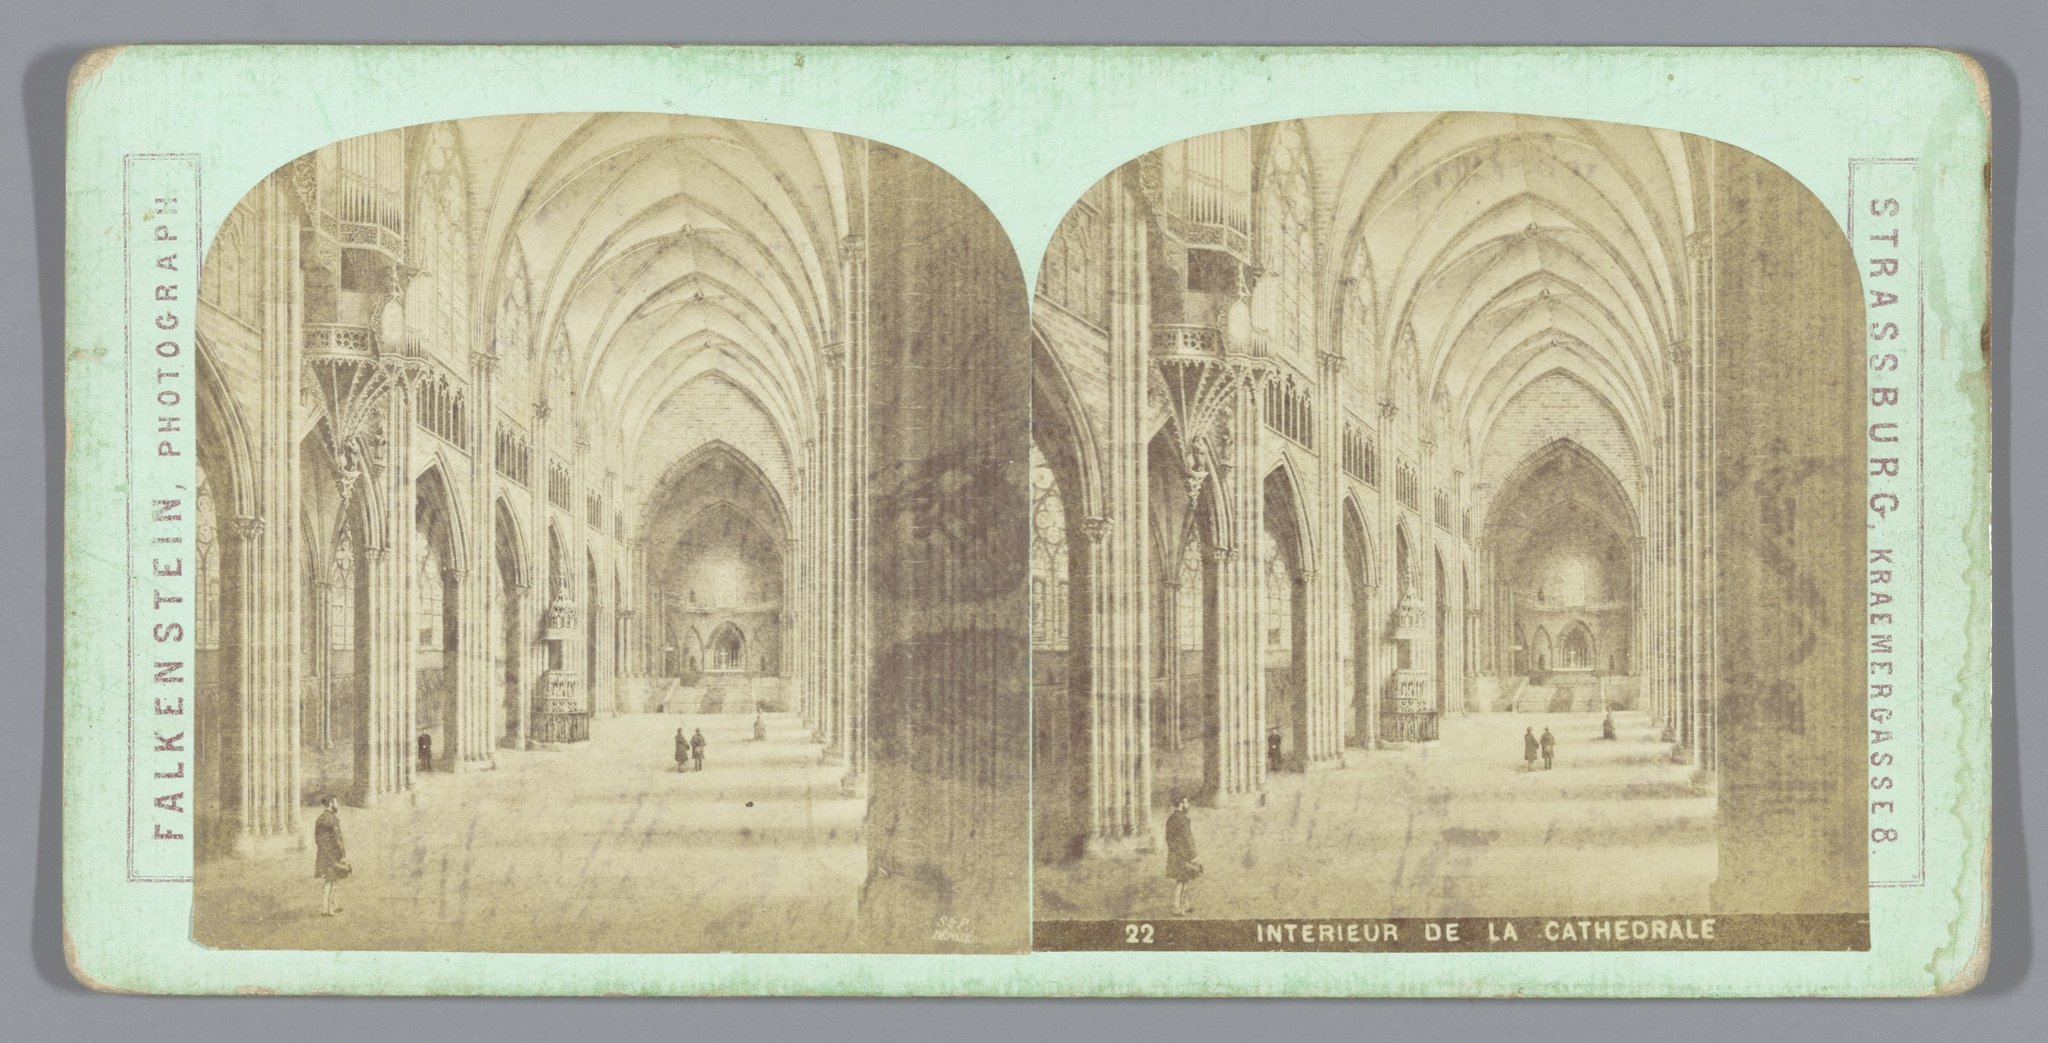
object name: stereograph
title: Gezicht op het interieur van het schip van de Notre-Dame in Straatsburg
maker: henri falkenstein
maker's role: fotograaf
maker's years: 1808-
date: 1860-1870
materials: cardboard, photographic support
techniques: albumen print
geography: notre-dame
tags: parts of church interior: nave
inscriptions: number: ‘22’